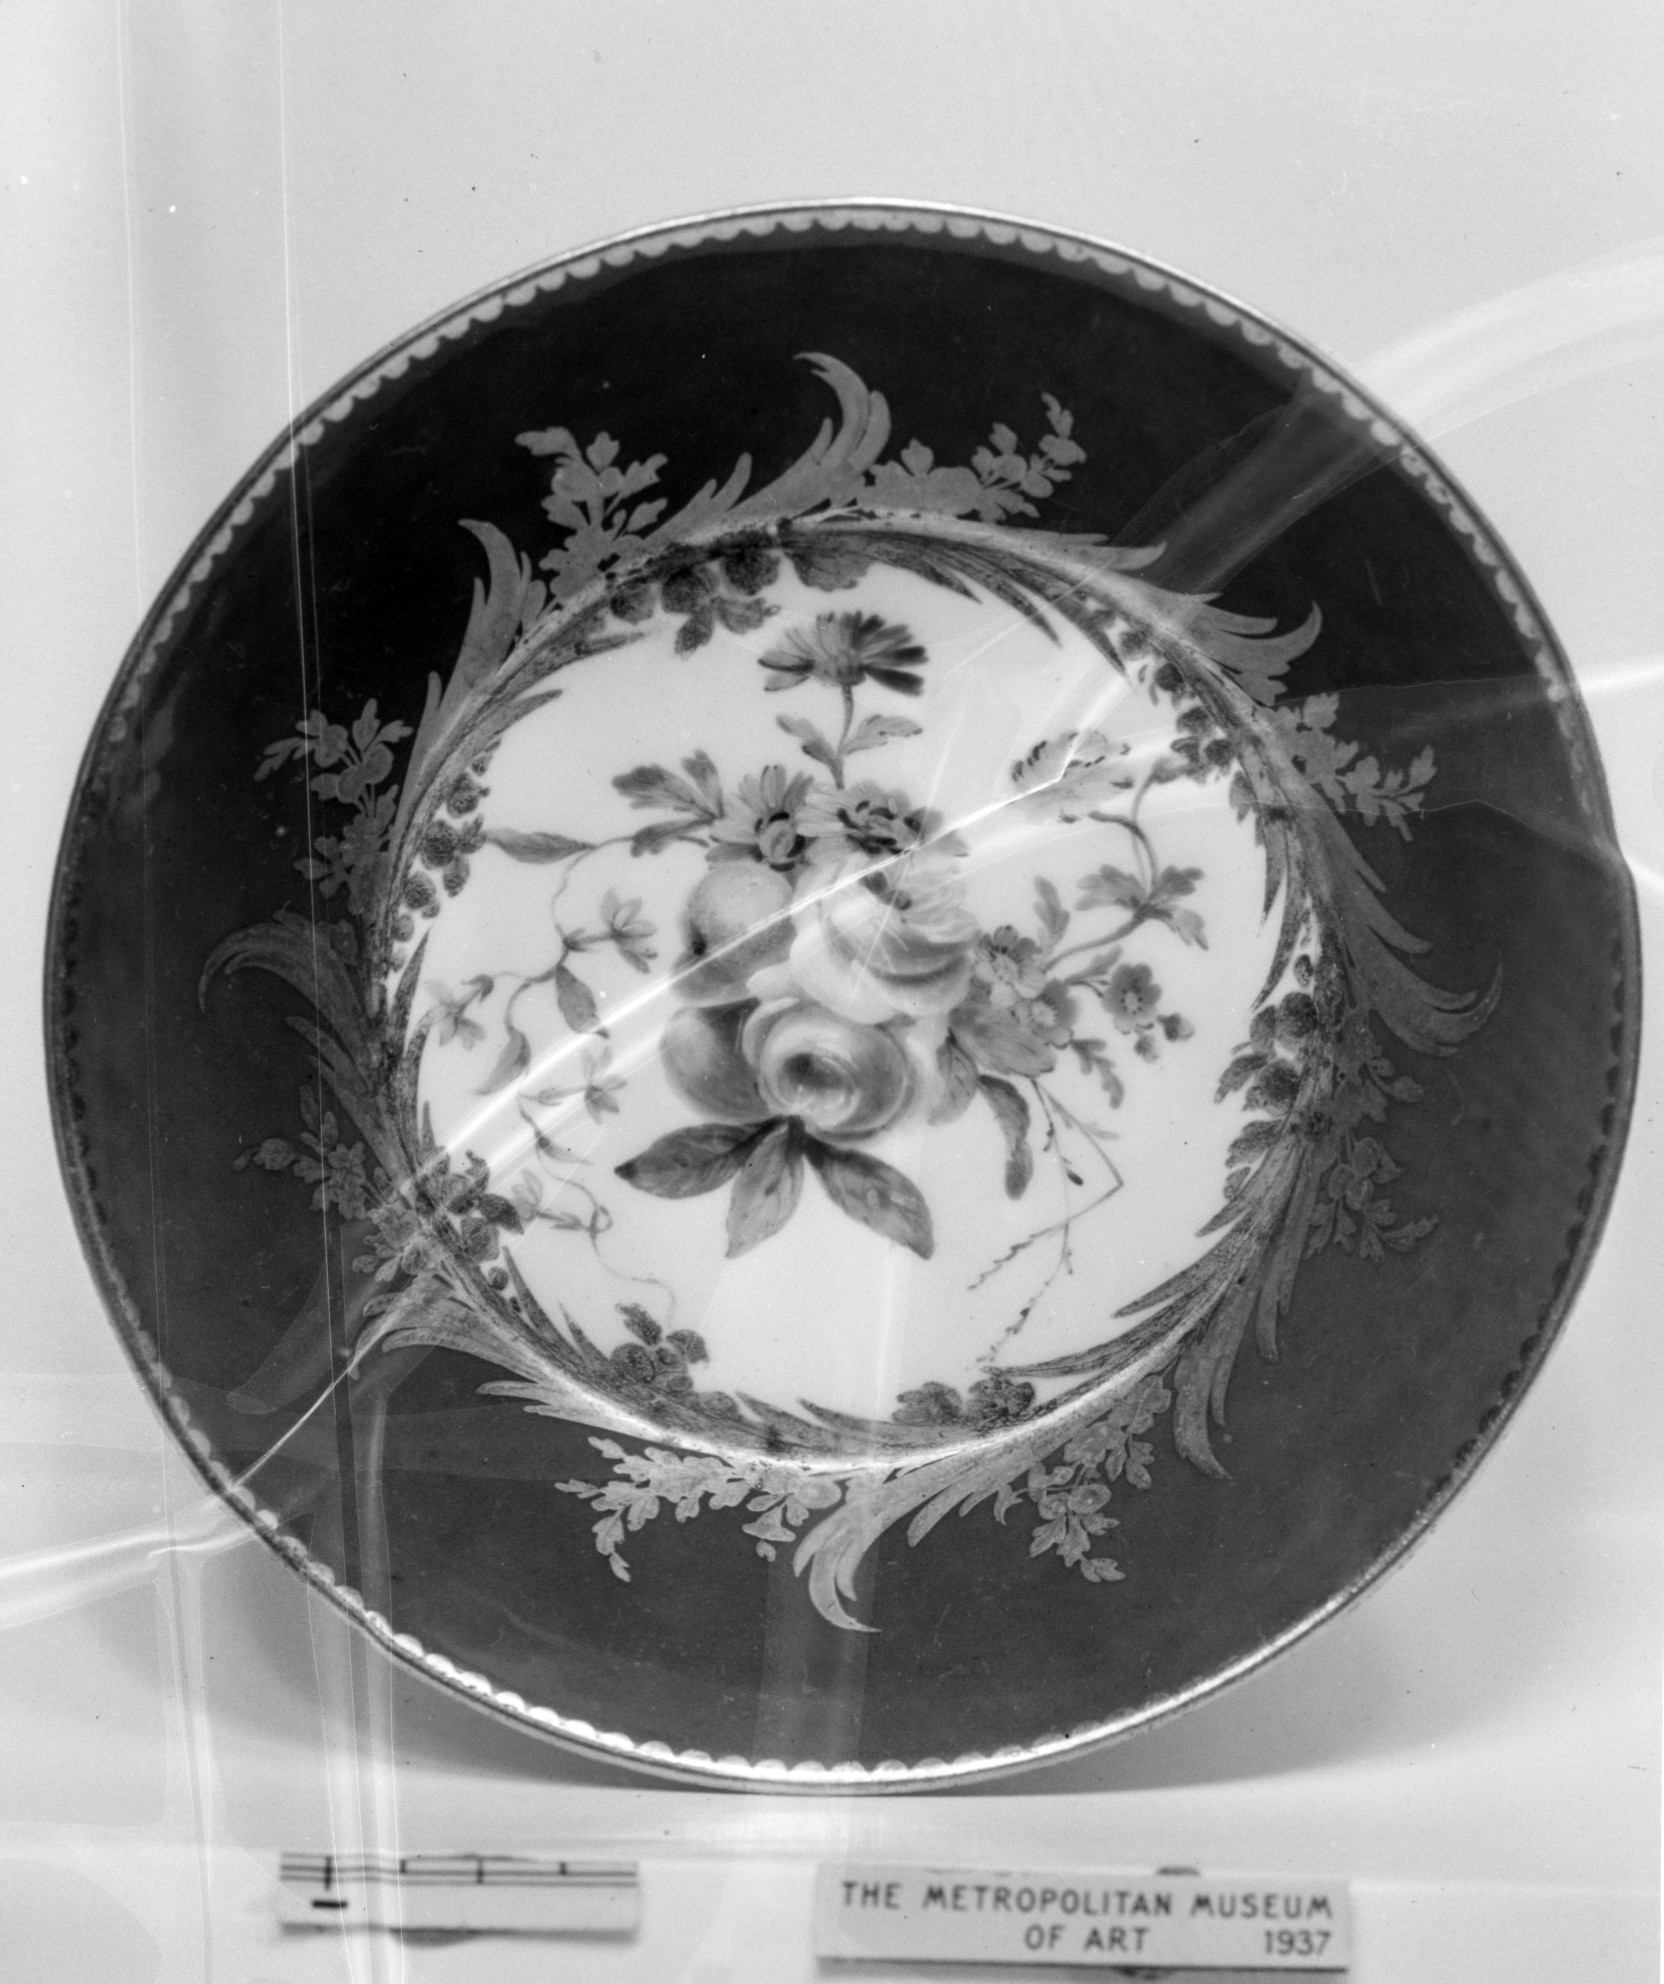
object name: saucer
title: Saucer (one of nine) (part of a service)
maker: sèvres manufactory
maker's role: manufactory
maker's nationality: french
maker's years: 1740-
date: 1787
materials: soft paste porcelain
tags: flowers